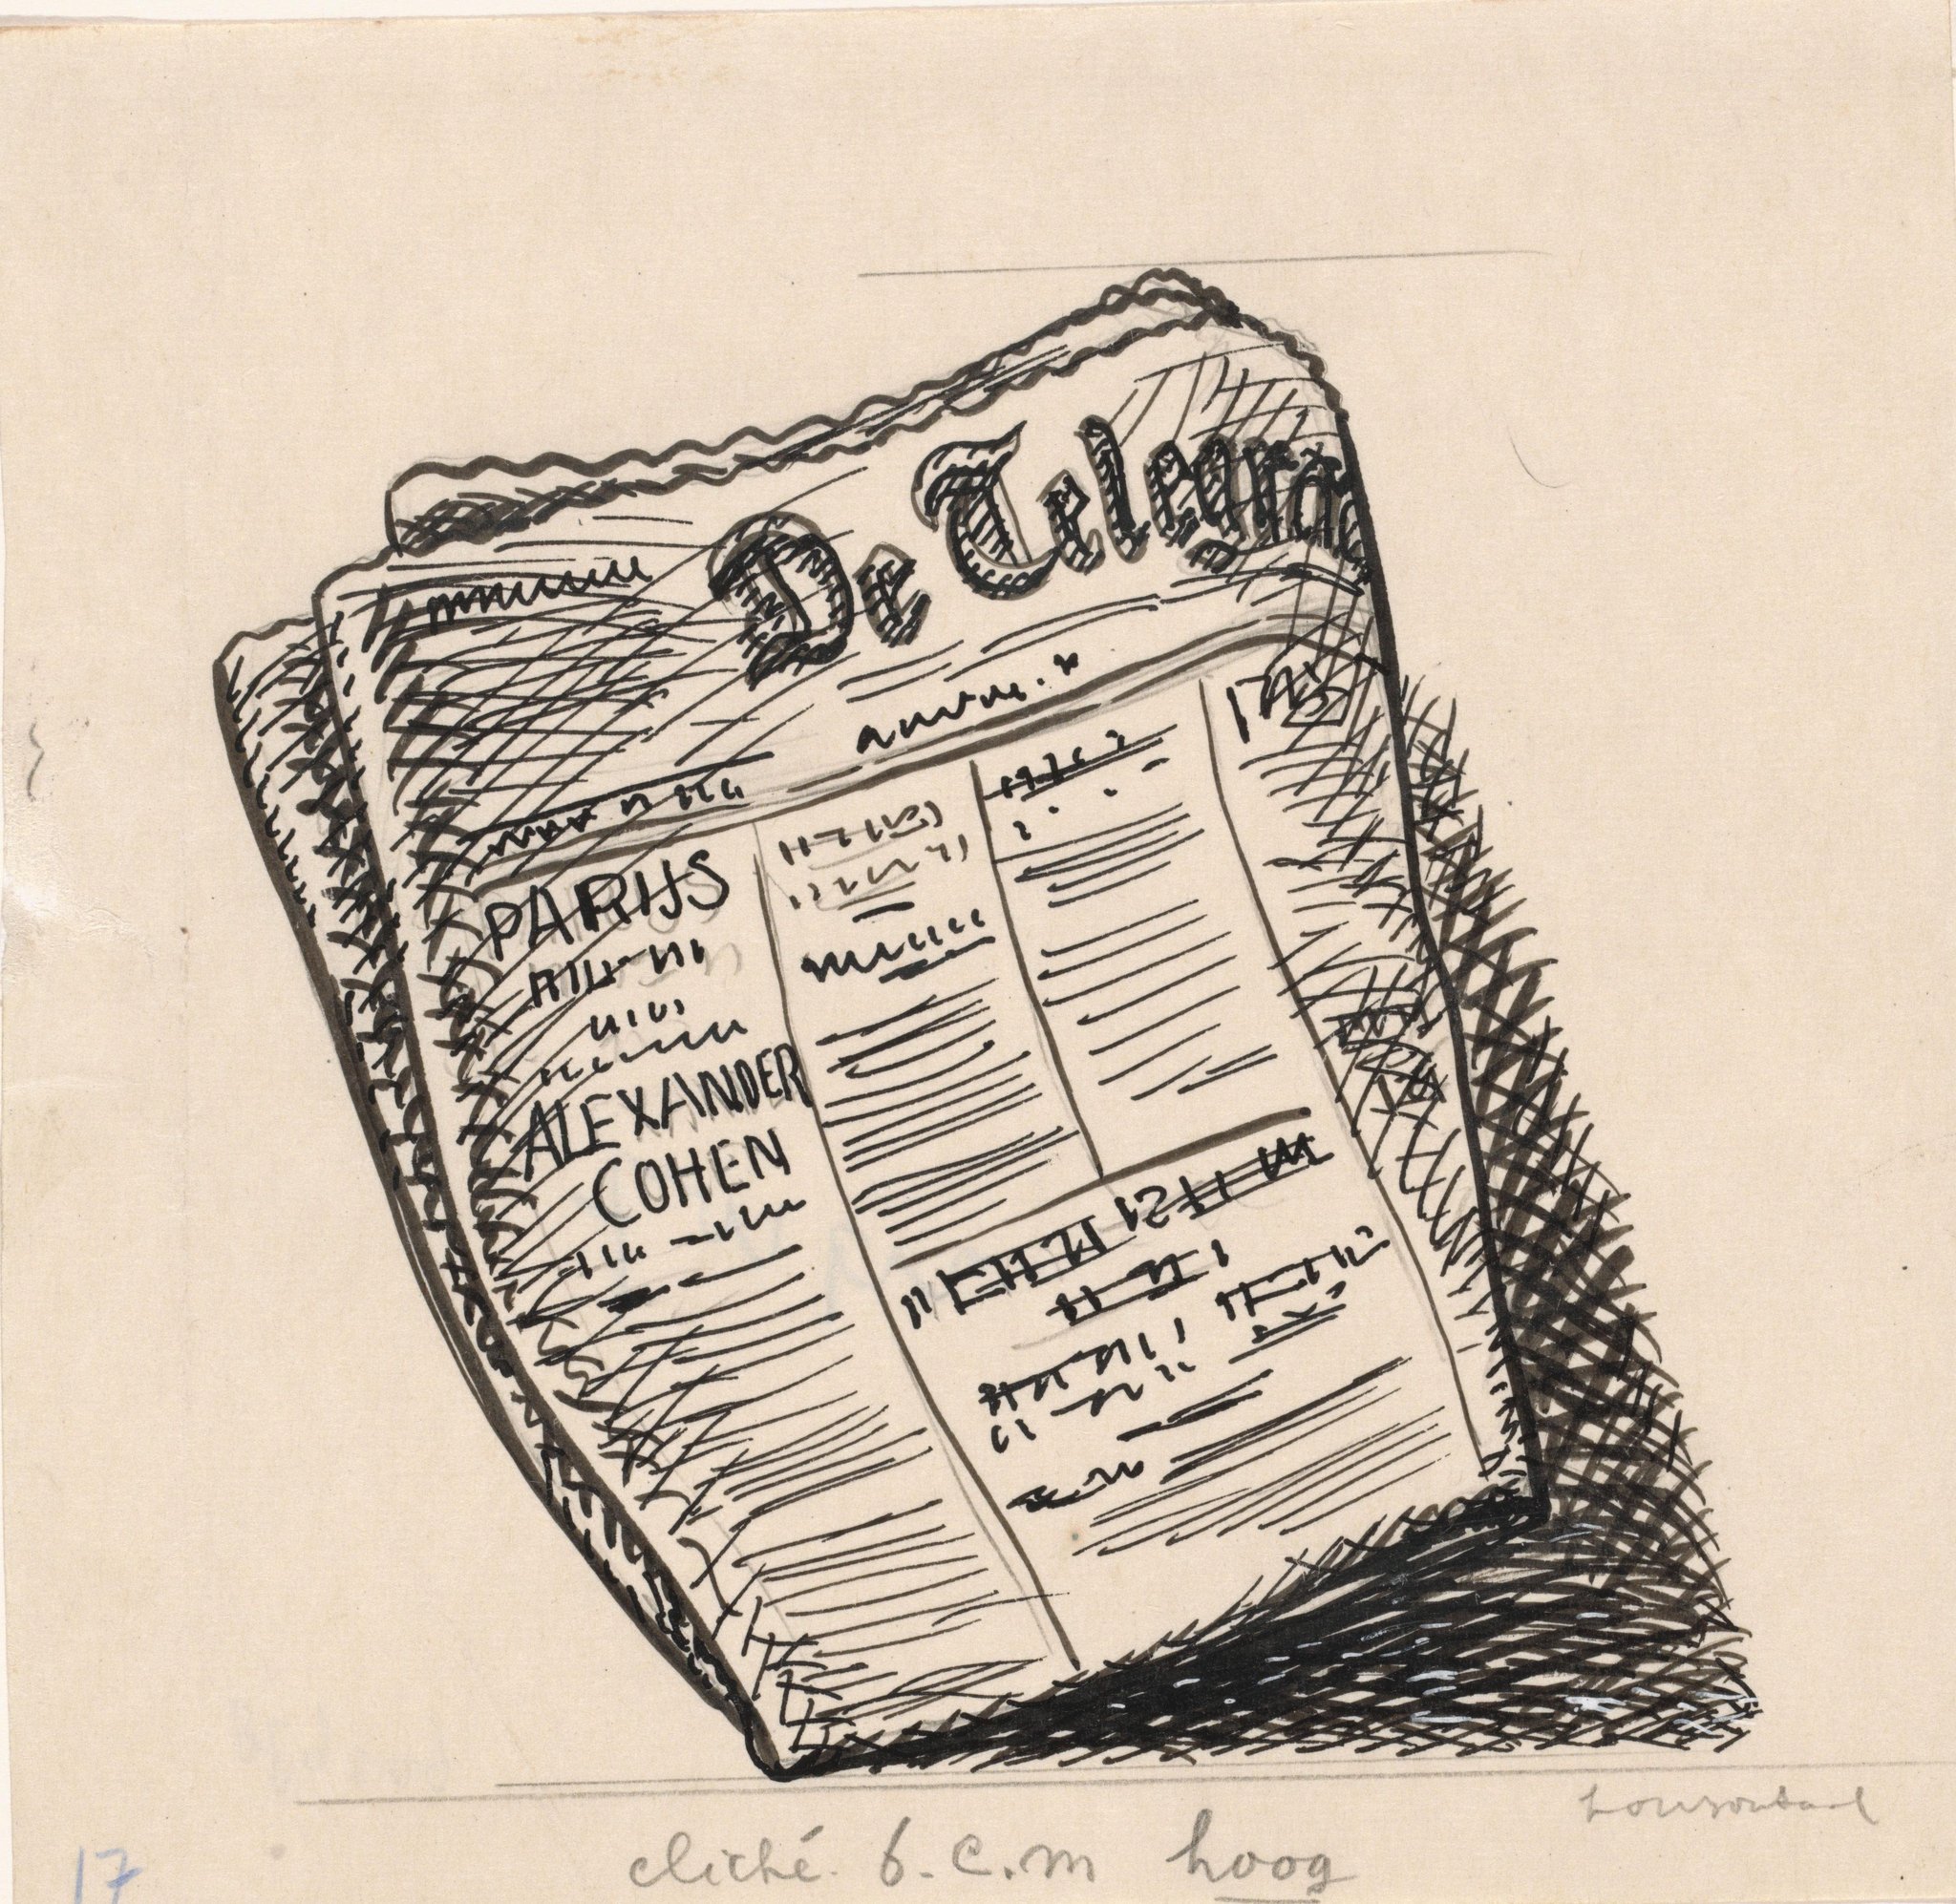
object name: boekillustratie ontwerp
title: Opgevouwen Telegraaf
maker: leo gestel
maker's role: draughtsman, print maker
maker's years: 1881-1941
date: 1934-1936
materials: ink, paper, pencil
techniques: pen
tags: (cohen, van anarchist tot monarchist) specific works of literature (with author, title), (other) historical names, newspaper, news-sheet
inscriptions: clichéaanwijzing, recto, handgeschreven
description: Ontwerp voor een boekillustratie voor: Cohen, Alexander. Van anarchist tot monarchist. Amsterdam: De Steenuil, 1936.